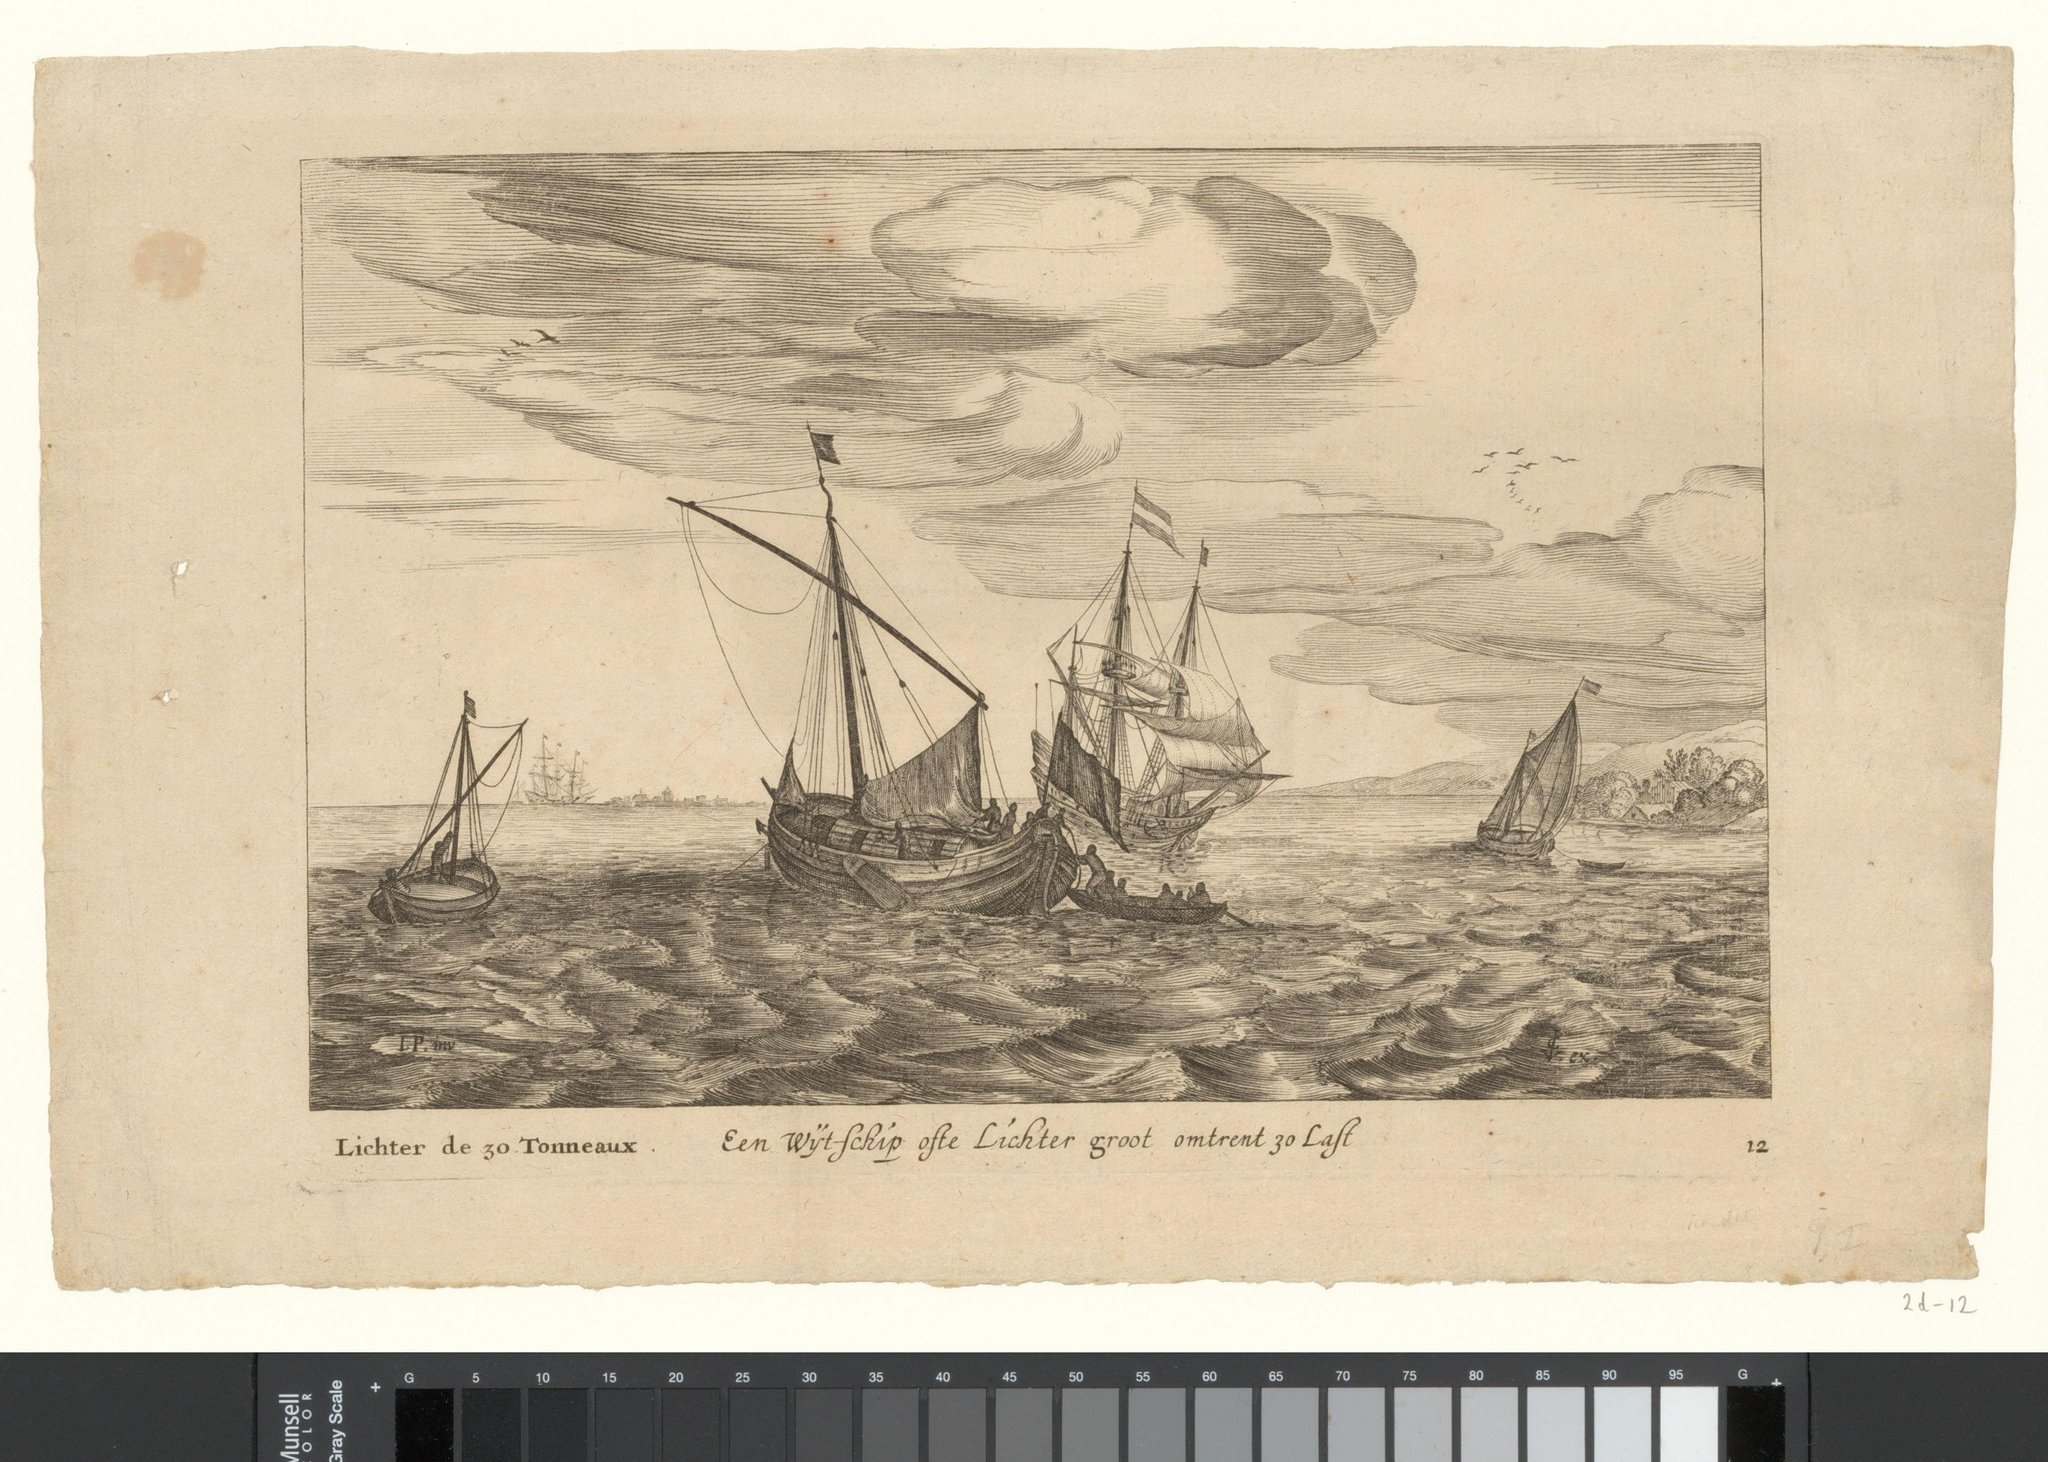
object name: print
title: Diverse navires dont on se sert dans les Provinces Unies / Icones variarum navium Hollandicarum quarum usus maximè in aquis interioribus regionis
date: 1717-1779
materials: paper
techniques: engraving, etching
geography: amsterdam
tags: sailing-ship, sailing-boat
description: Een wijdschip of lichter op het water. Rechtsonder genummerd: 12. Onderwerpsrubrieken binnen de Atlas Zeden en Gewoonten: Handel, Nijverheid en Verkeer, Scheepsvaart.